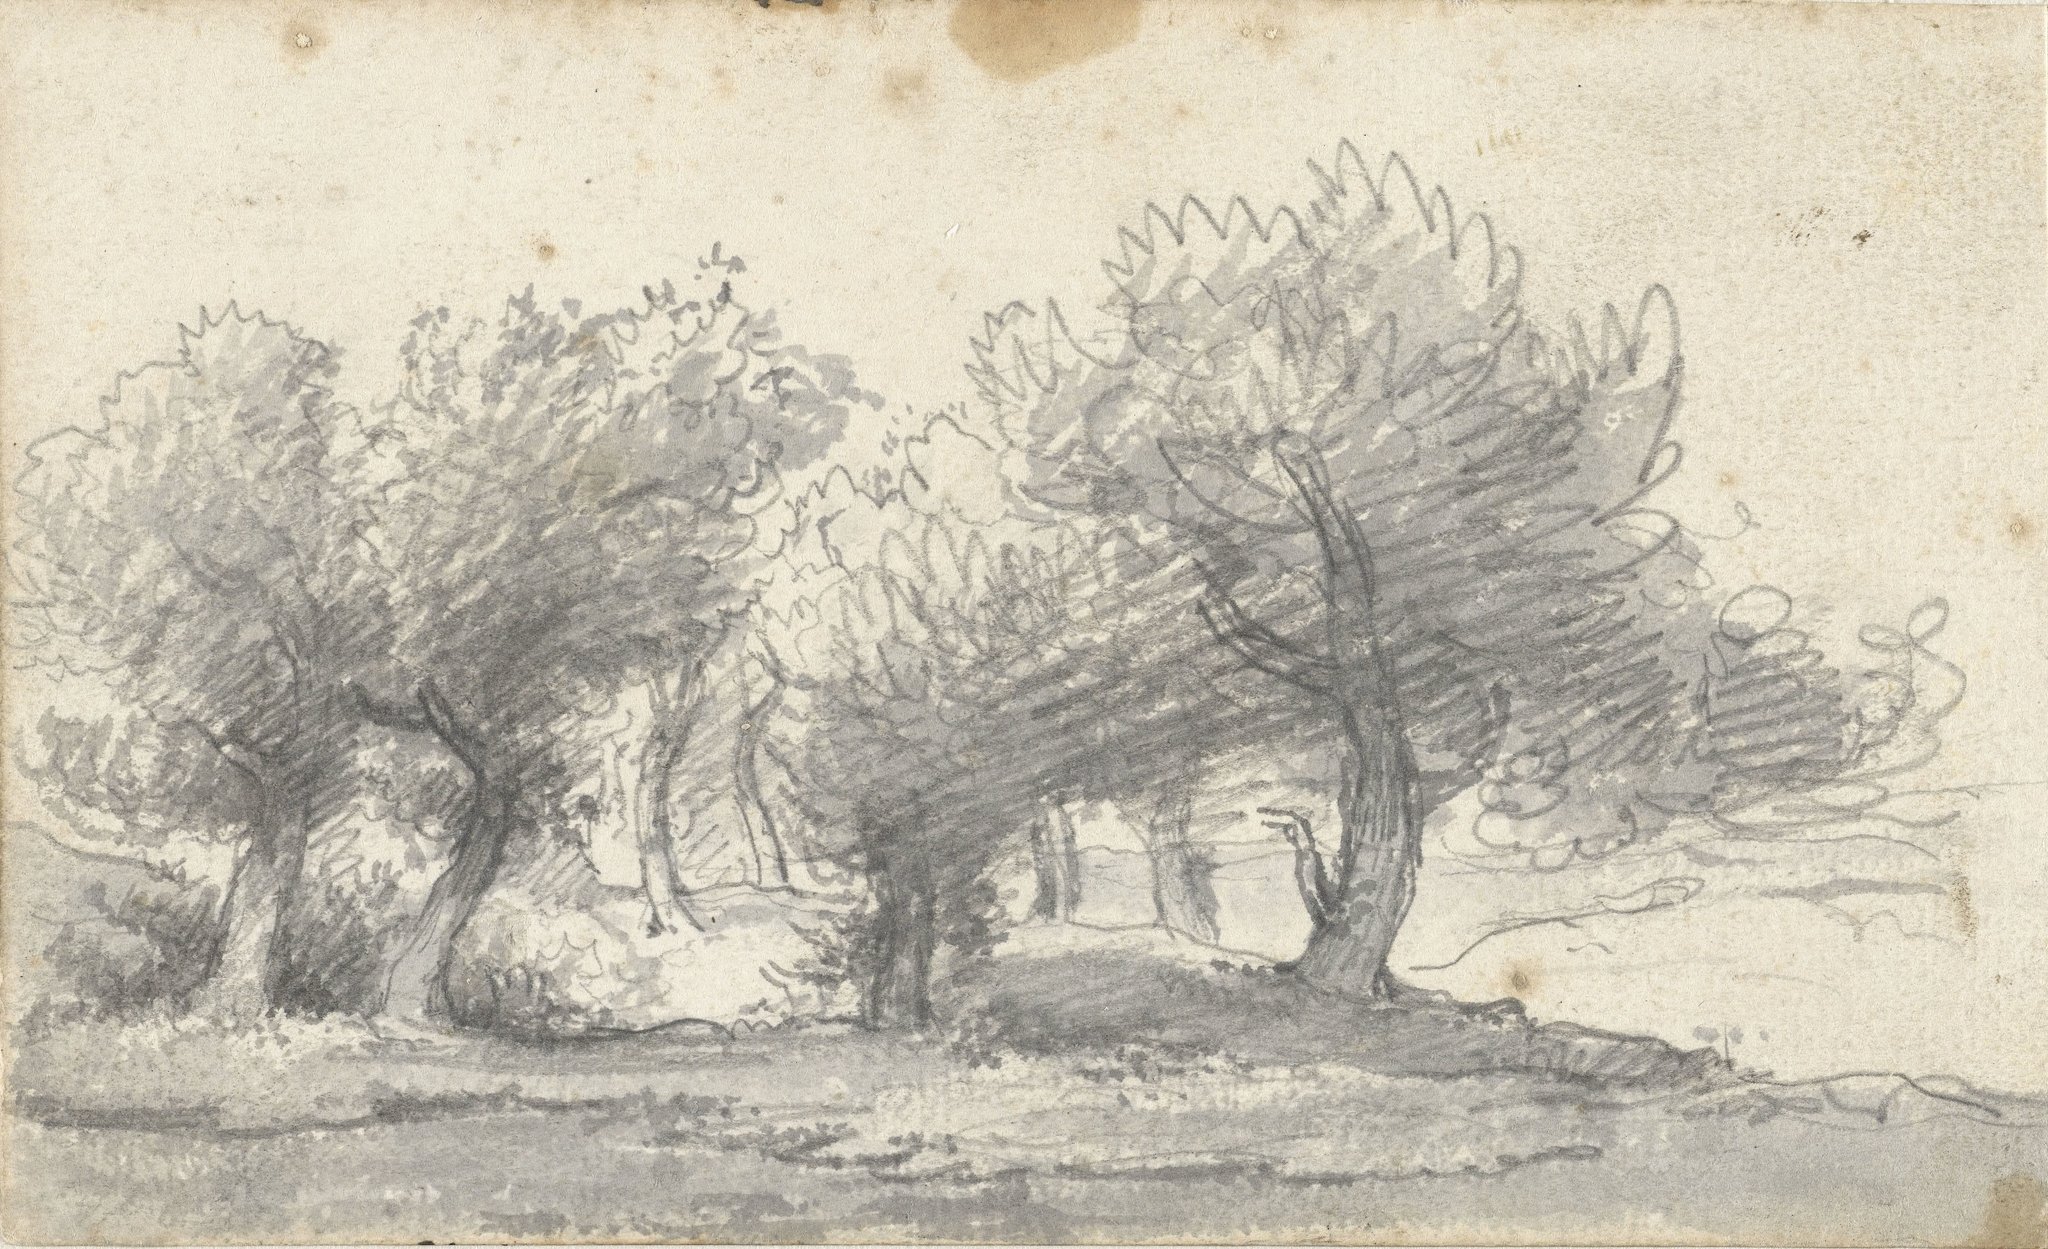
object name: drawing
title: Landschap met bomen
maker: arnoldus johannes eymer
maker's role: draughtsman, print maker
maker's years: 1803-1863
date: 1813-1863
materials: paper, pencil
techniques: brush